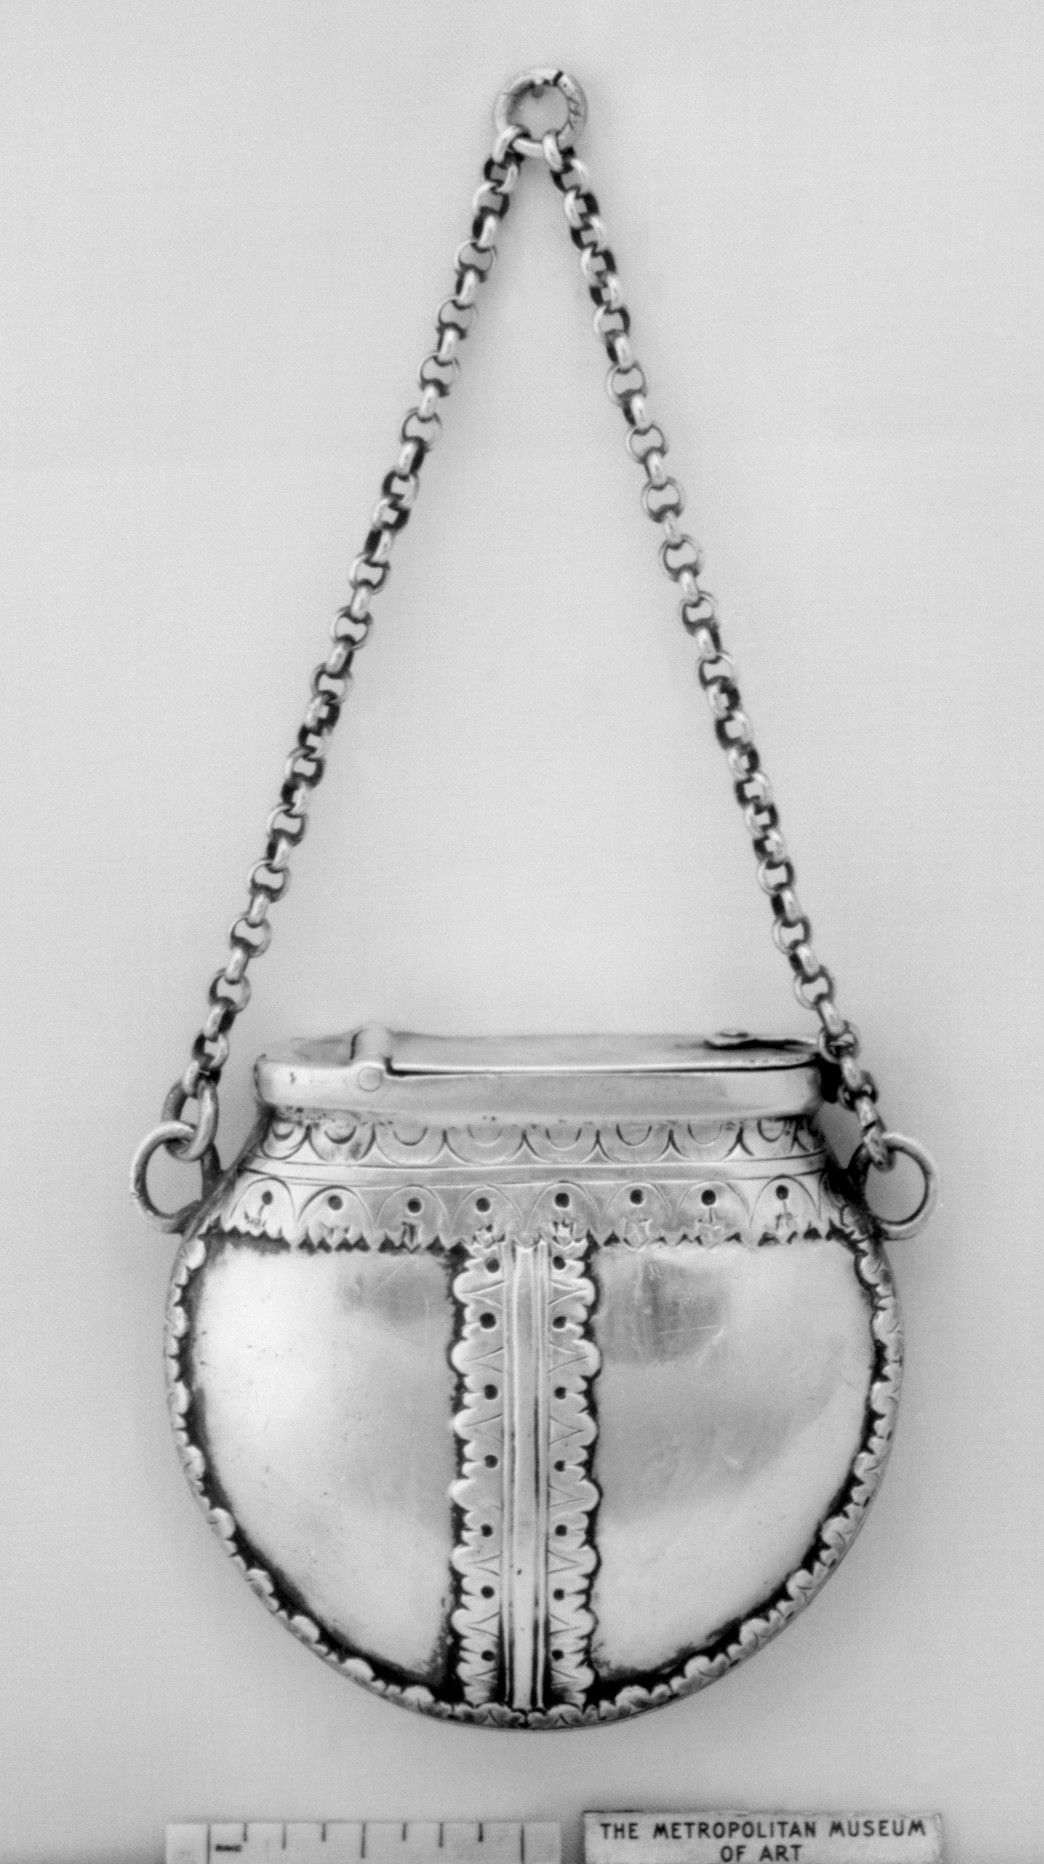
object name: box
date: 1601-1700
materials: silver